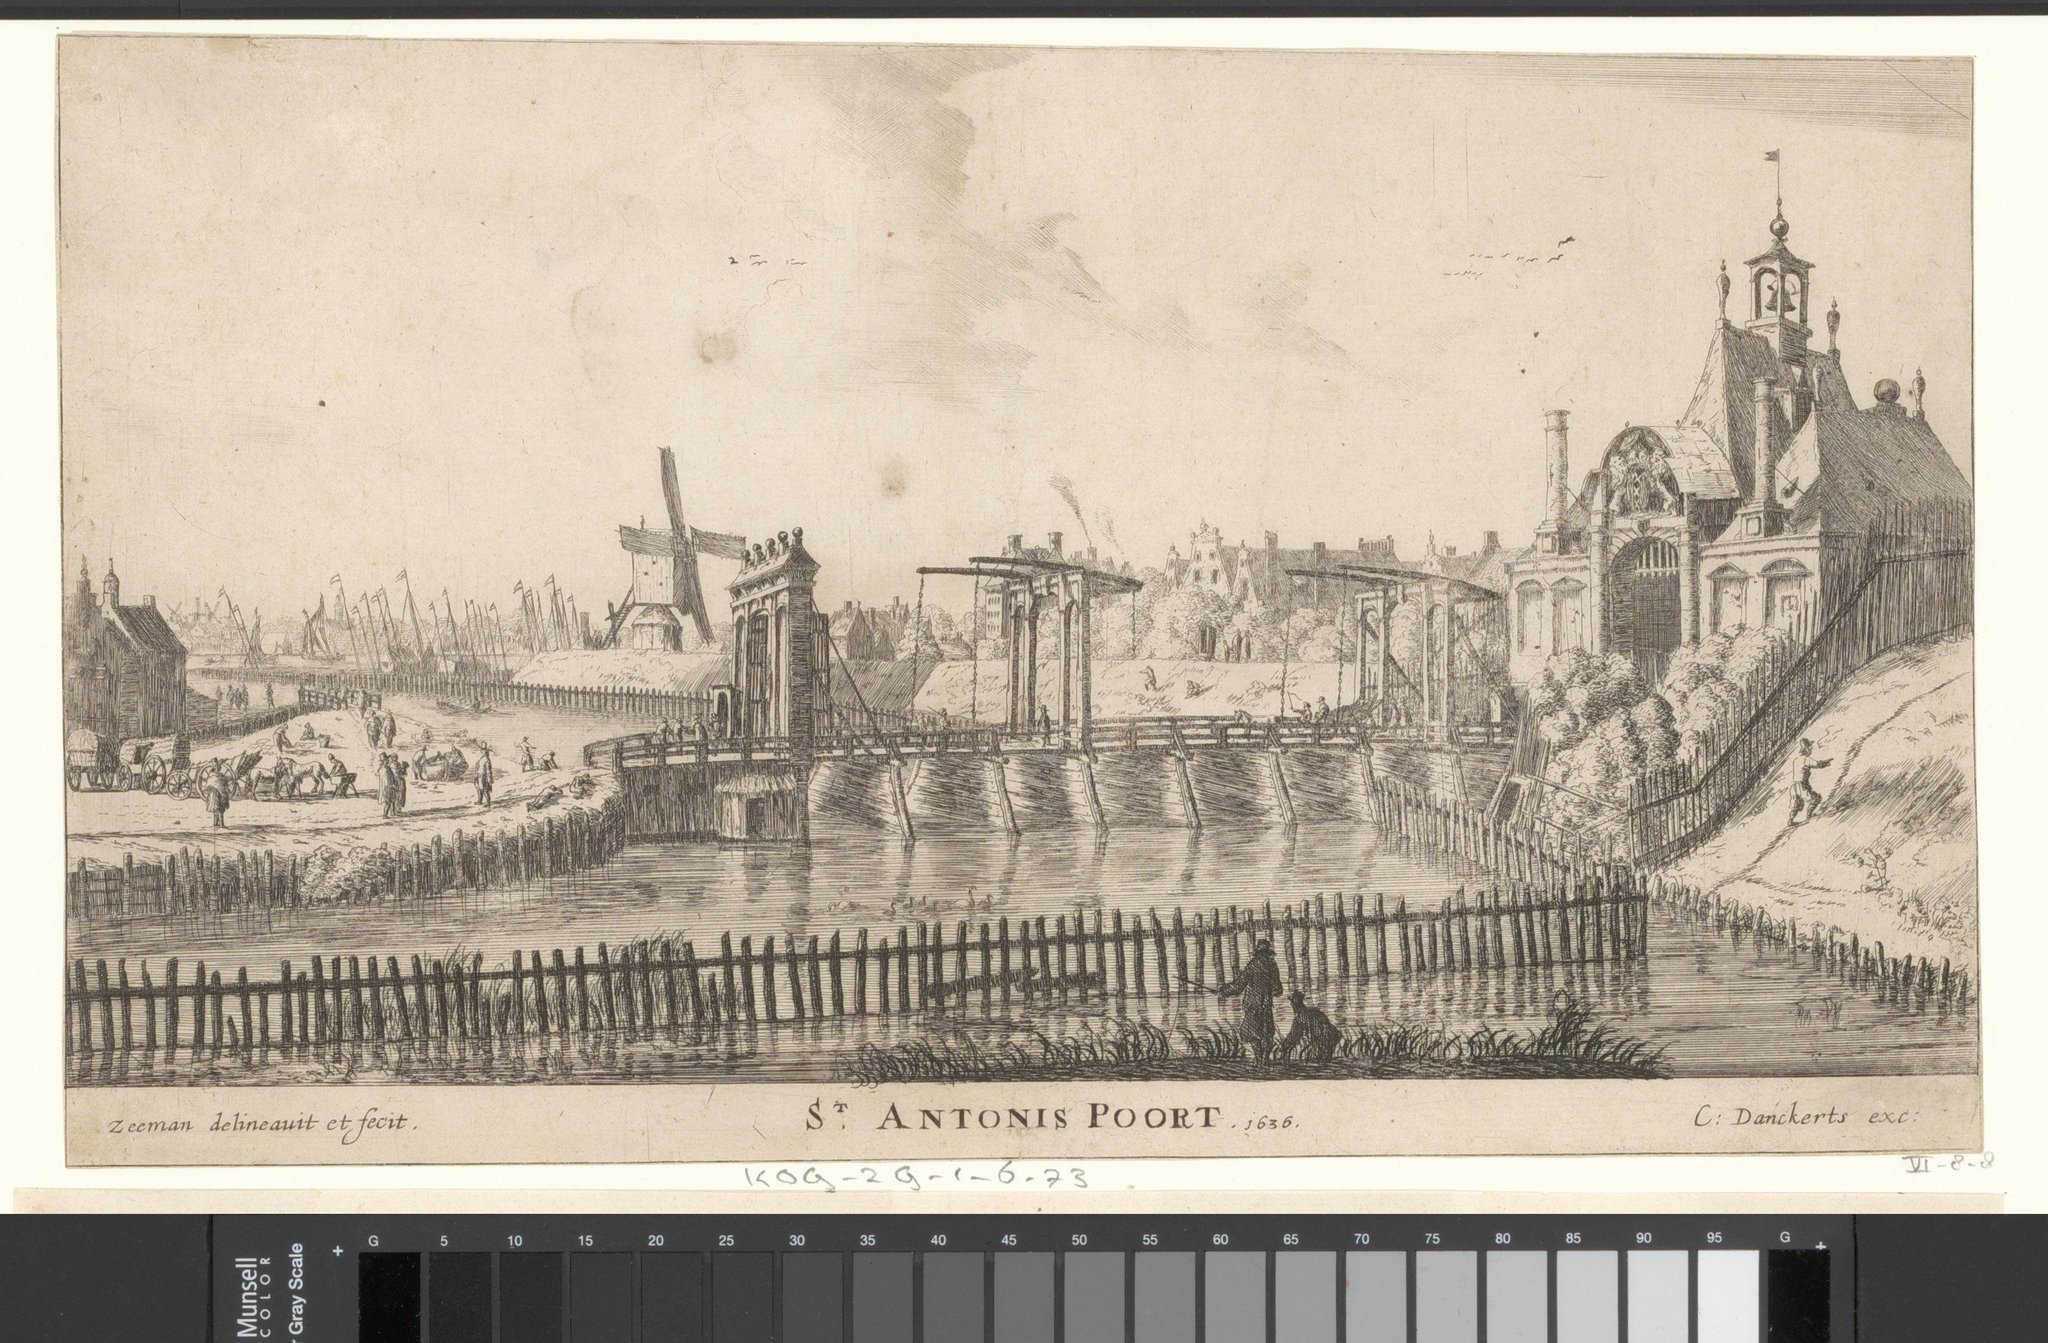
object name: print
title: St. Antonis Poort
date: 1654-1701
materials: paper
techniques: engraving, etching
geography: amsterdam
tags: tower, clock tower ~ monumental adornment, windmill, city-gate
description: Onderdeel van een prentserie bestaande uit een titelprent en zeven prenten van Amsterdamse stadspoorten of alleen zeven (of zes) prenten van Amsterdamse stadspoorten. Van deze prentserie zijn drie uitgaven bekend, respectievelijk uitgegeven door Cornelis Danckerts (I), Dancker Danckerts en Justus Danckerts. Van de titelprent zijn drie staten bekend: één staat voor de letter waarop het droge naaldwerk nog goed zichtbaar is, één staat waarop Dancker Danckerts als uitgever vermeld staat; en één staat waarop Justus Danckerts als uitgever vermeld staat. De serie uitgegeven door Cornelis (I) Danckerts had mogelijk geen titelprent. Van elk van de overige prenten zijn redelijk wat exemplaren overgeleverd maar is telkens slechts één staat bekend. Op vier van deze prenten staat Cornelis Danckerts (I) vermeld als uitgever. Op twee prenten staat geen uitgever vermeld en op één prent staat Dancker Danckerts vermeld als uitgever. Mogelijk hebben zowel Dancker als Justus voor hun uitgave hun naam op de titelprent vermeld zonder de overige prenten bij te werken. Dat zou betekenen dat de prenten waarop Cornelis (I) staat vermeld als uitgever, ook later door zijn zoons Dancker en Justus kunnen zijn uitgegeven. En dat de prent waarop Danker vermeld staat als uitgever ook door Justus kan zijn uitgeven. Dat op de prent van de Derde Regulierspoort (RP-P-AO-27-15-2 en RP-P-1882-A-6003) wel - in een net andere stijl - de naam van Dancker Danckerts staat, zou verklaard kunnen worden doordat deze prent iets later, na het overlijden van Cornelis (I) in 1656, aan de serie is toegevoegd. De serie bevat namelijk ook een prent van de Tweede Regulierspoort (RP-P-AO-27-4-2 en huidige prent). Deze houten poort werd in 1654 afgebroken en vervangen door de stenen Derde Regulierspoort die in 1655 voltooid zou zijn.